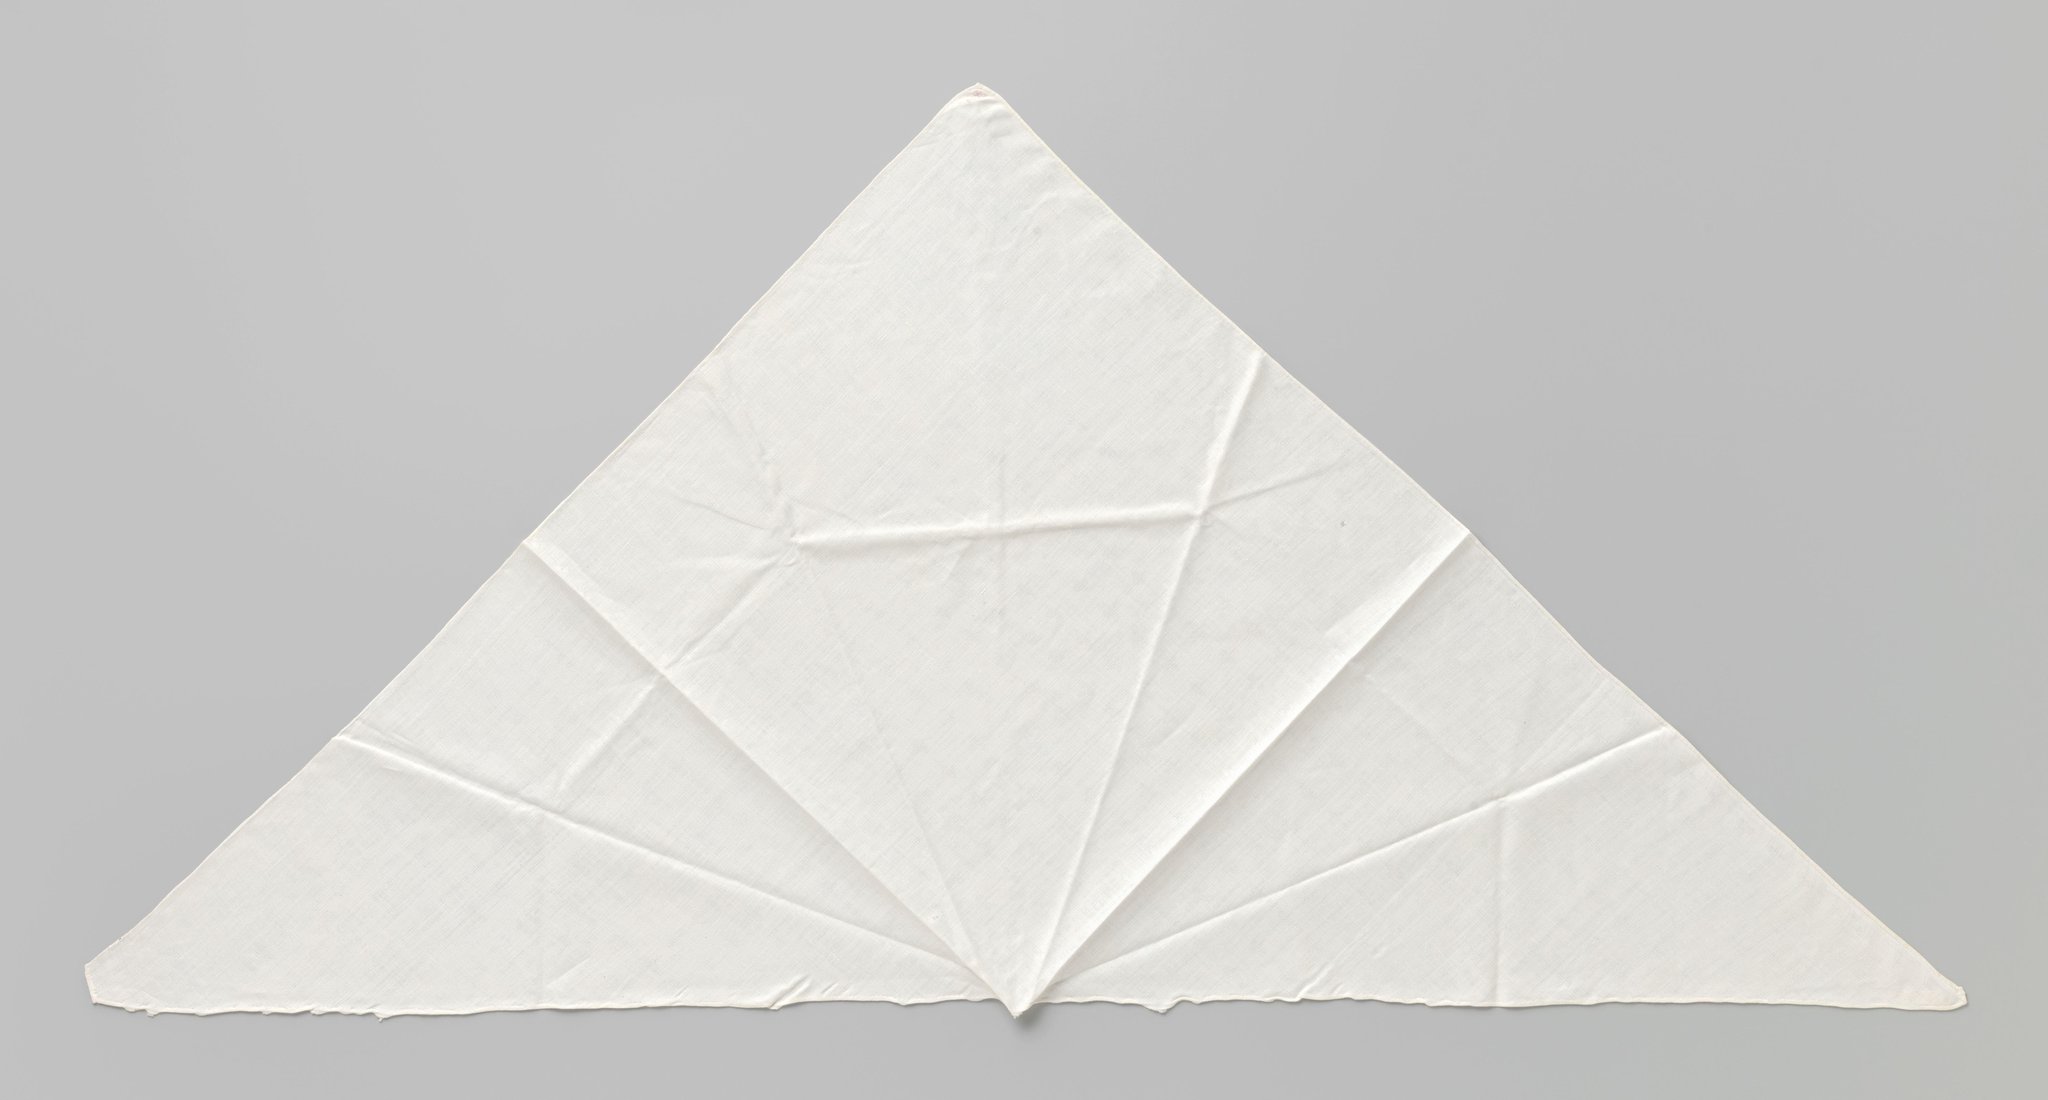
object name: womenswear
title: Fichu, driehoekig, gemaakt van een servet van linnendamast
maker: Anonymous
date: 1825-1850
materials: linen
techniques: cross stitching, damask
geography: netherlands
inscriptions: initials: ‘BS // 12’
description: Driekante fichu van een linnen damast servet geknipt, met patroon van gestrooid klaverblaadje, zonder randpatroon. Gemerkt B.S. /24 (Berkhout-v. Slingerlandt) Nederland. Toestand: In 1979 gewassen. De draad v.d. zoom op de schuine zijde is herhaaldelijk kapotgetrokken, vanwege de rekbaarheid daar.